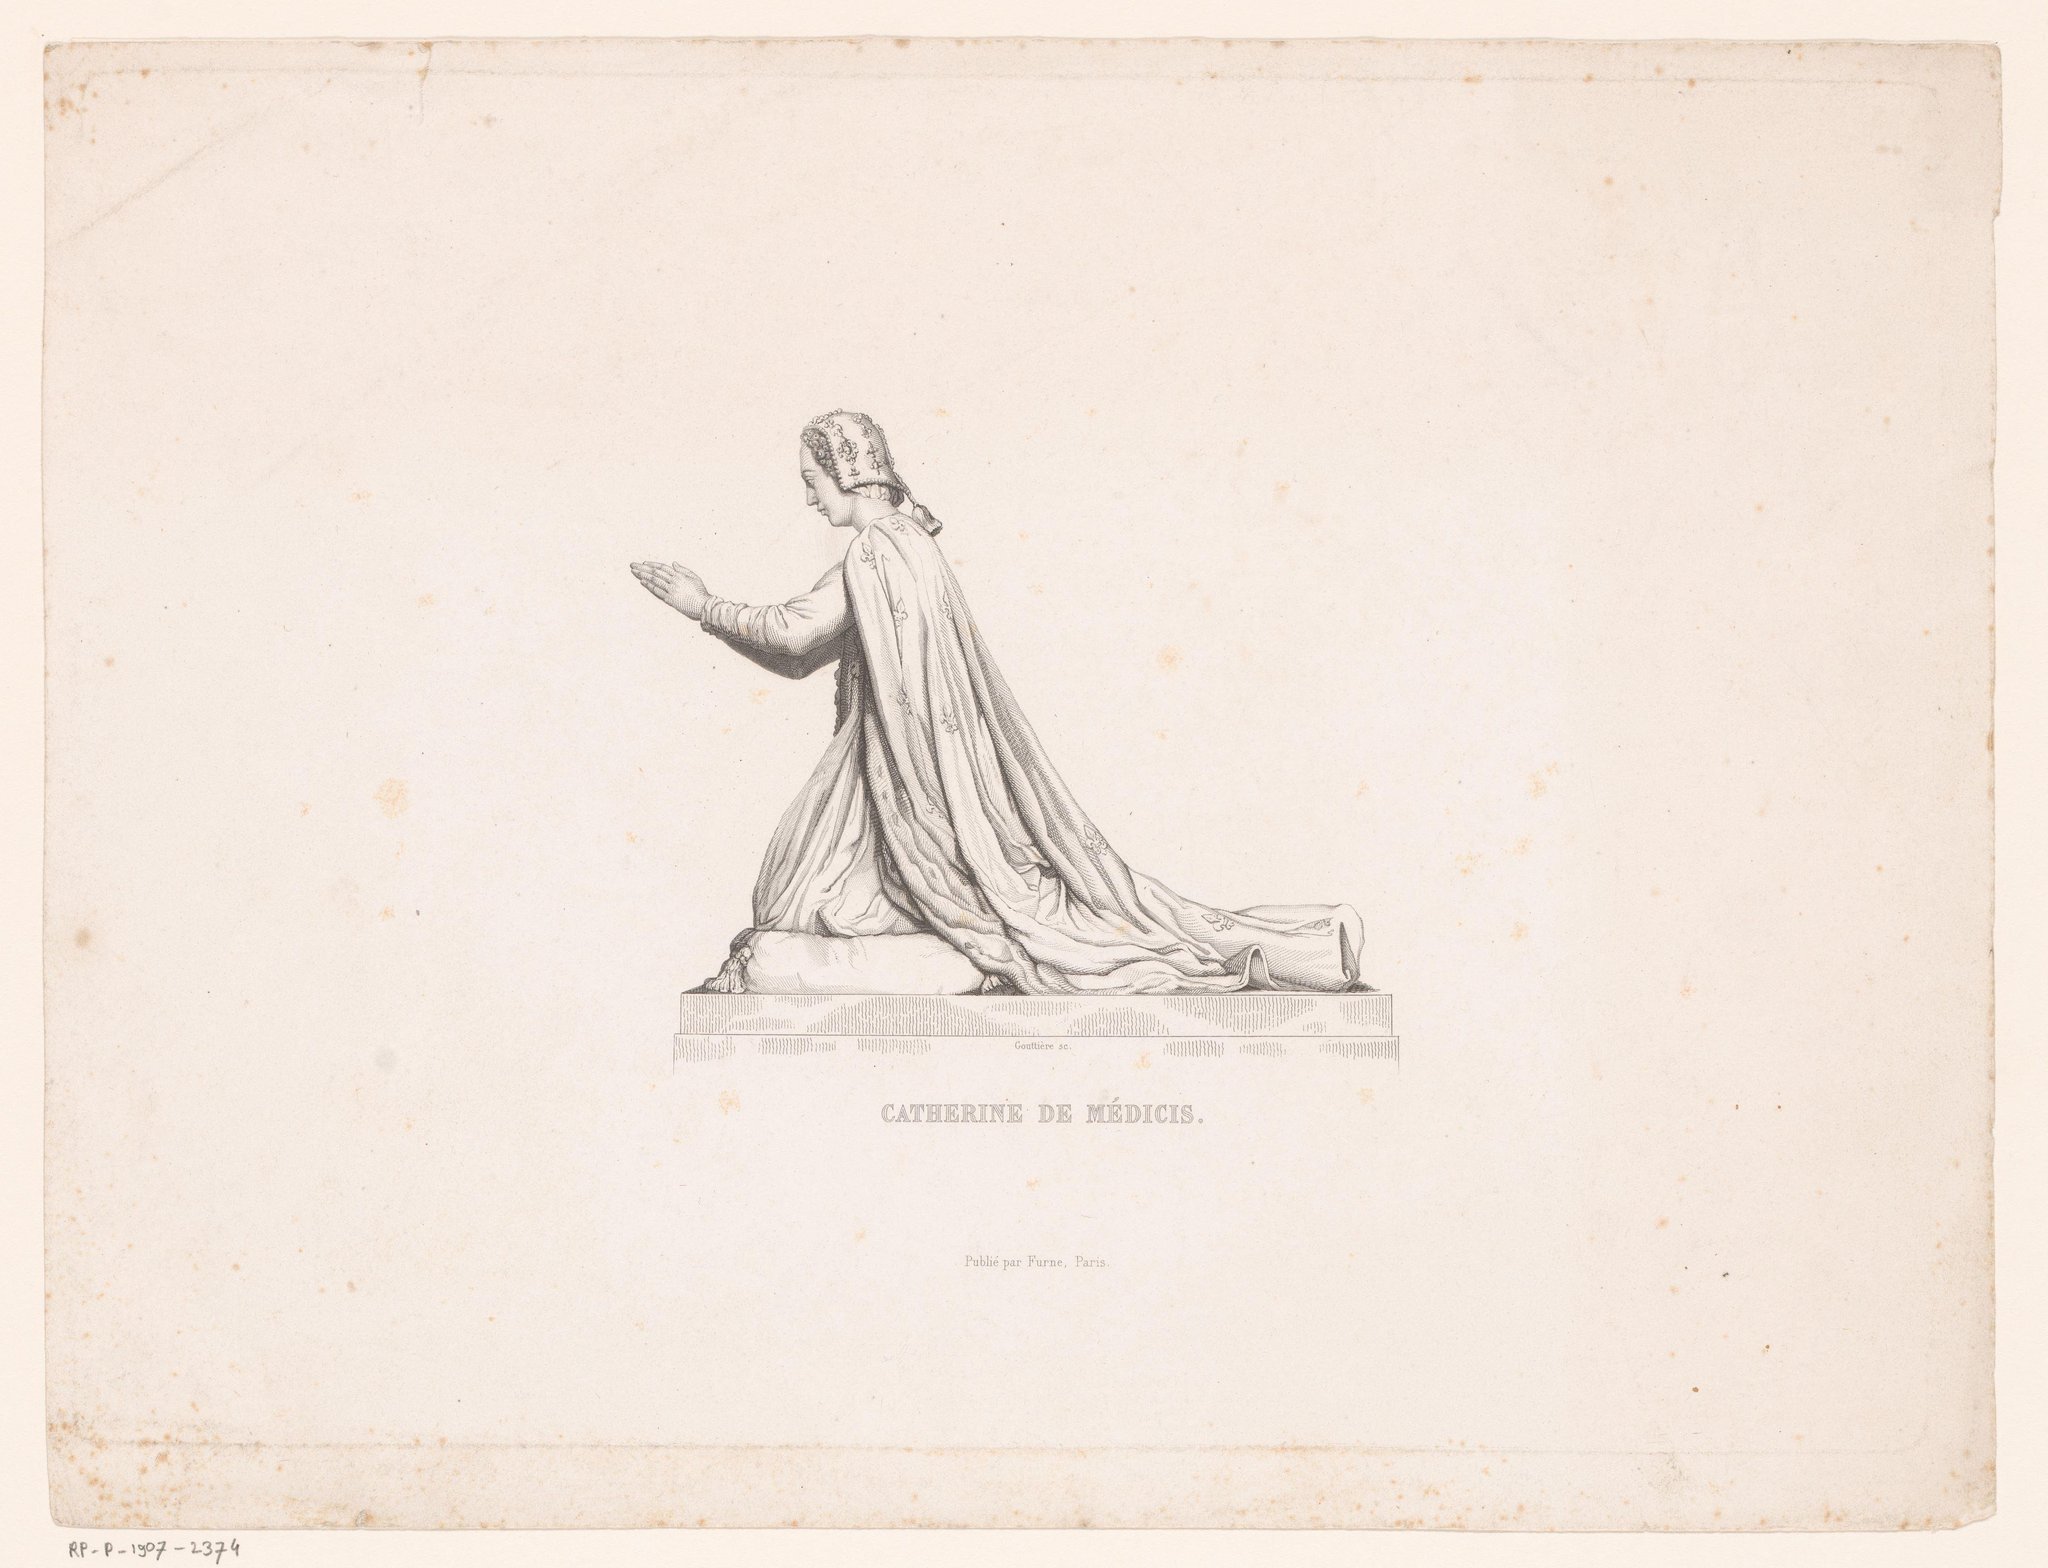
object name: print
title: Catherine de Médicis.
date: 1818-1859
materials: paper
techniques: etching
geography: paris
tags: historical persons, grave, tomb, sculpture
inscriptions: collector's mark: Lugt 2228